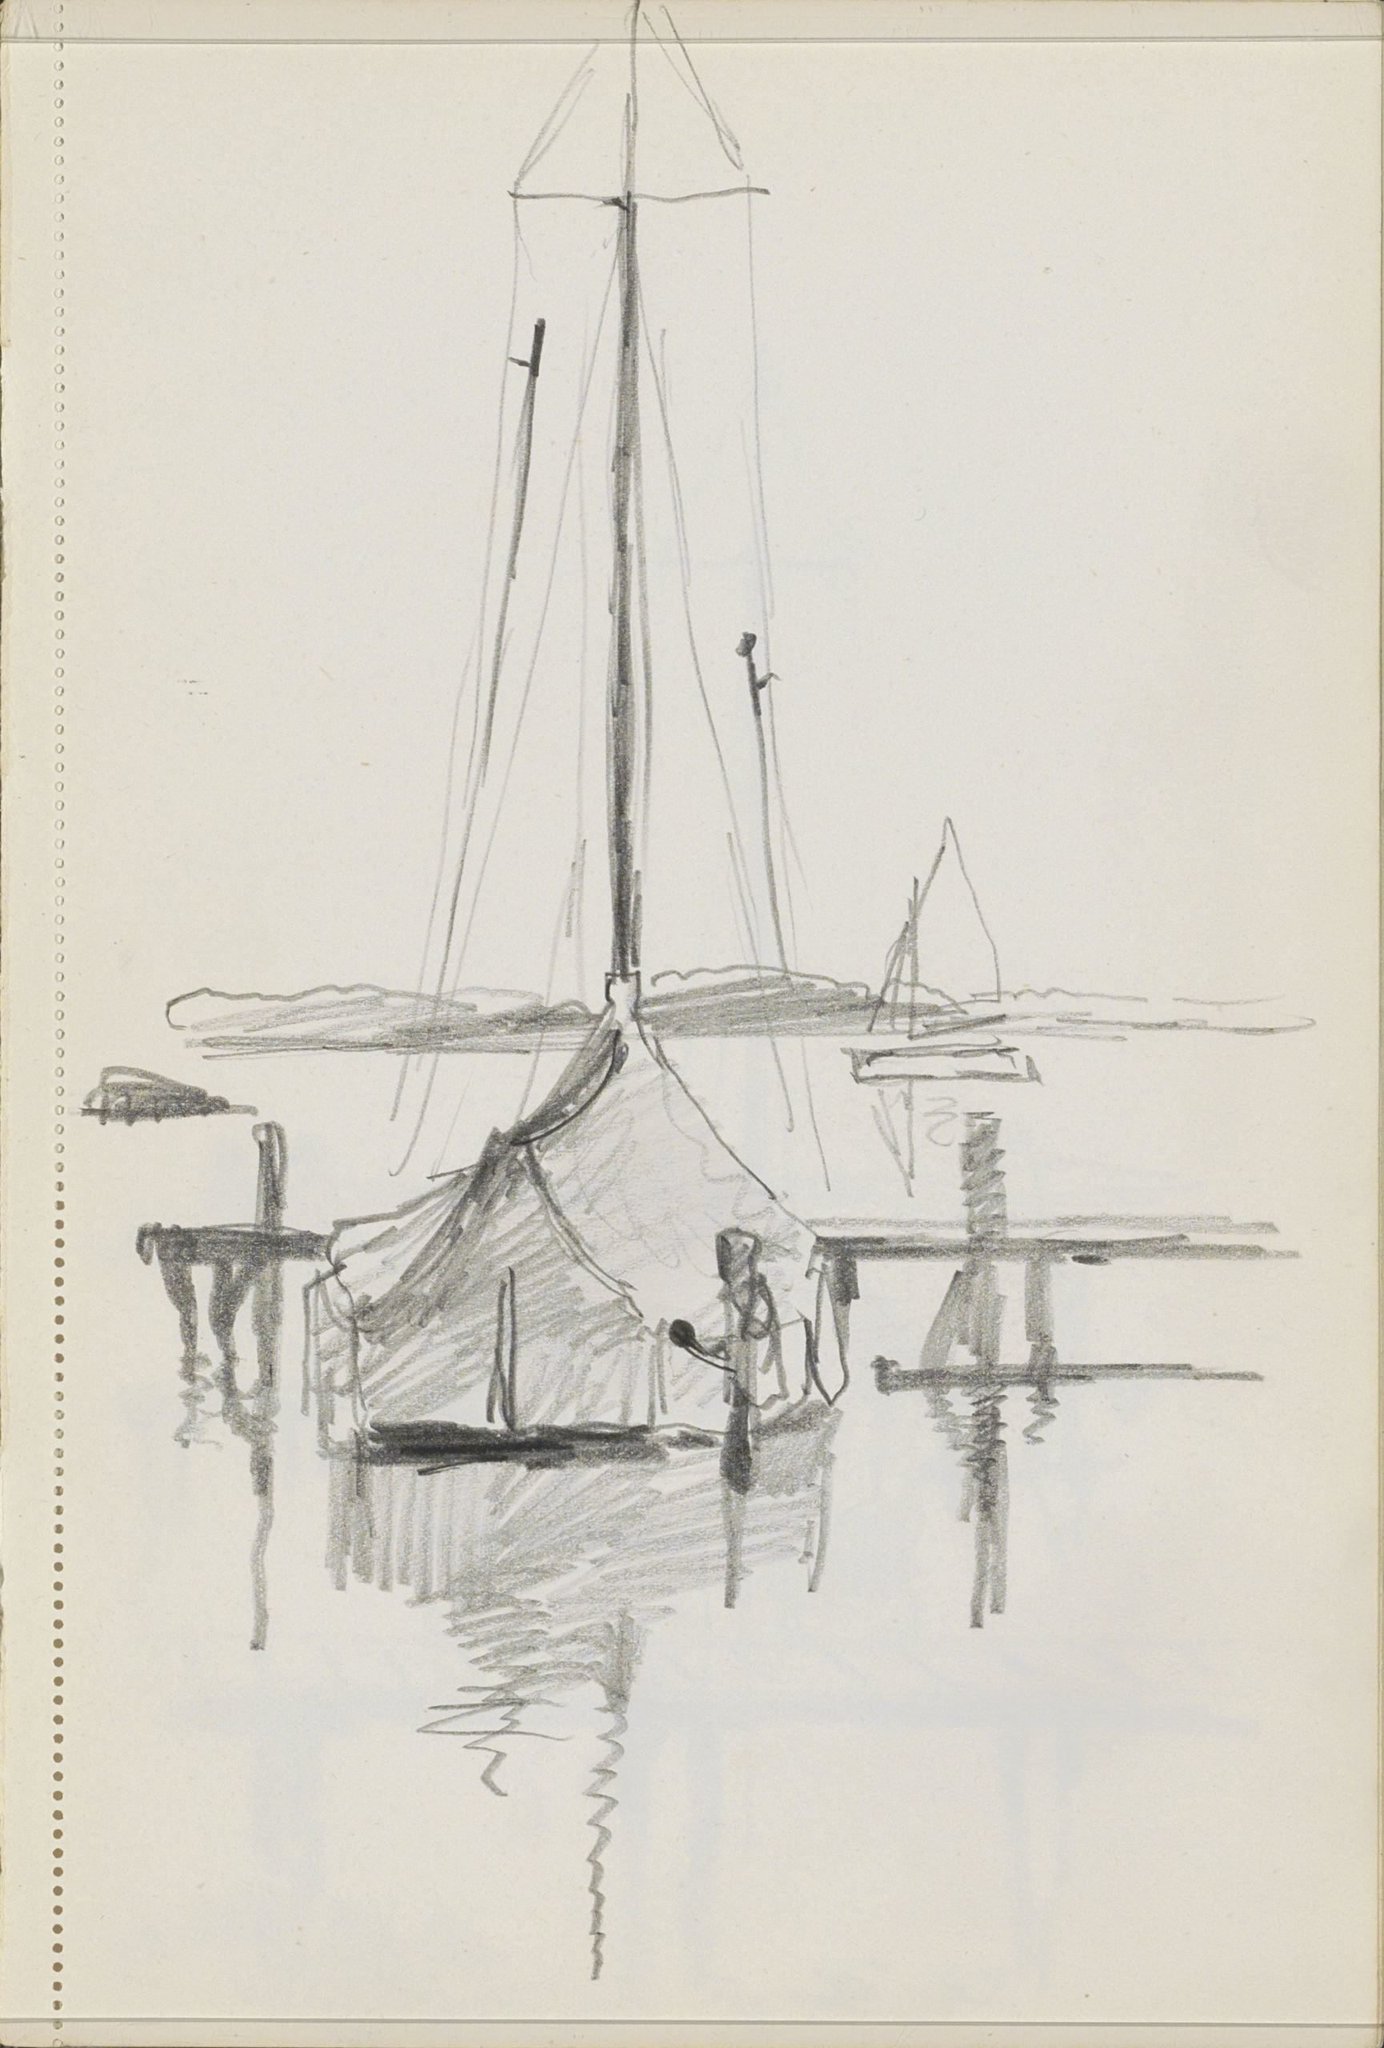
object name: sketchbook leaf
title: Aangemeerde zeilboot bij een steiger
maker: cornelis vreedenburgh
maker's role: draughtsman, print maker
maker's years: 1880-1946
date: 1890-1946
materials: paper, pencil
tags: sailing-ship, sailing-boat, pier, quay, wharf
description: Blad 36 recto uit een schetsboek met uit 75 bladen.